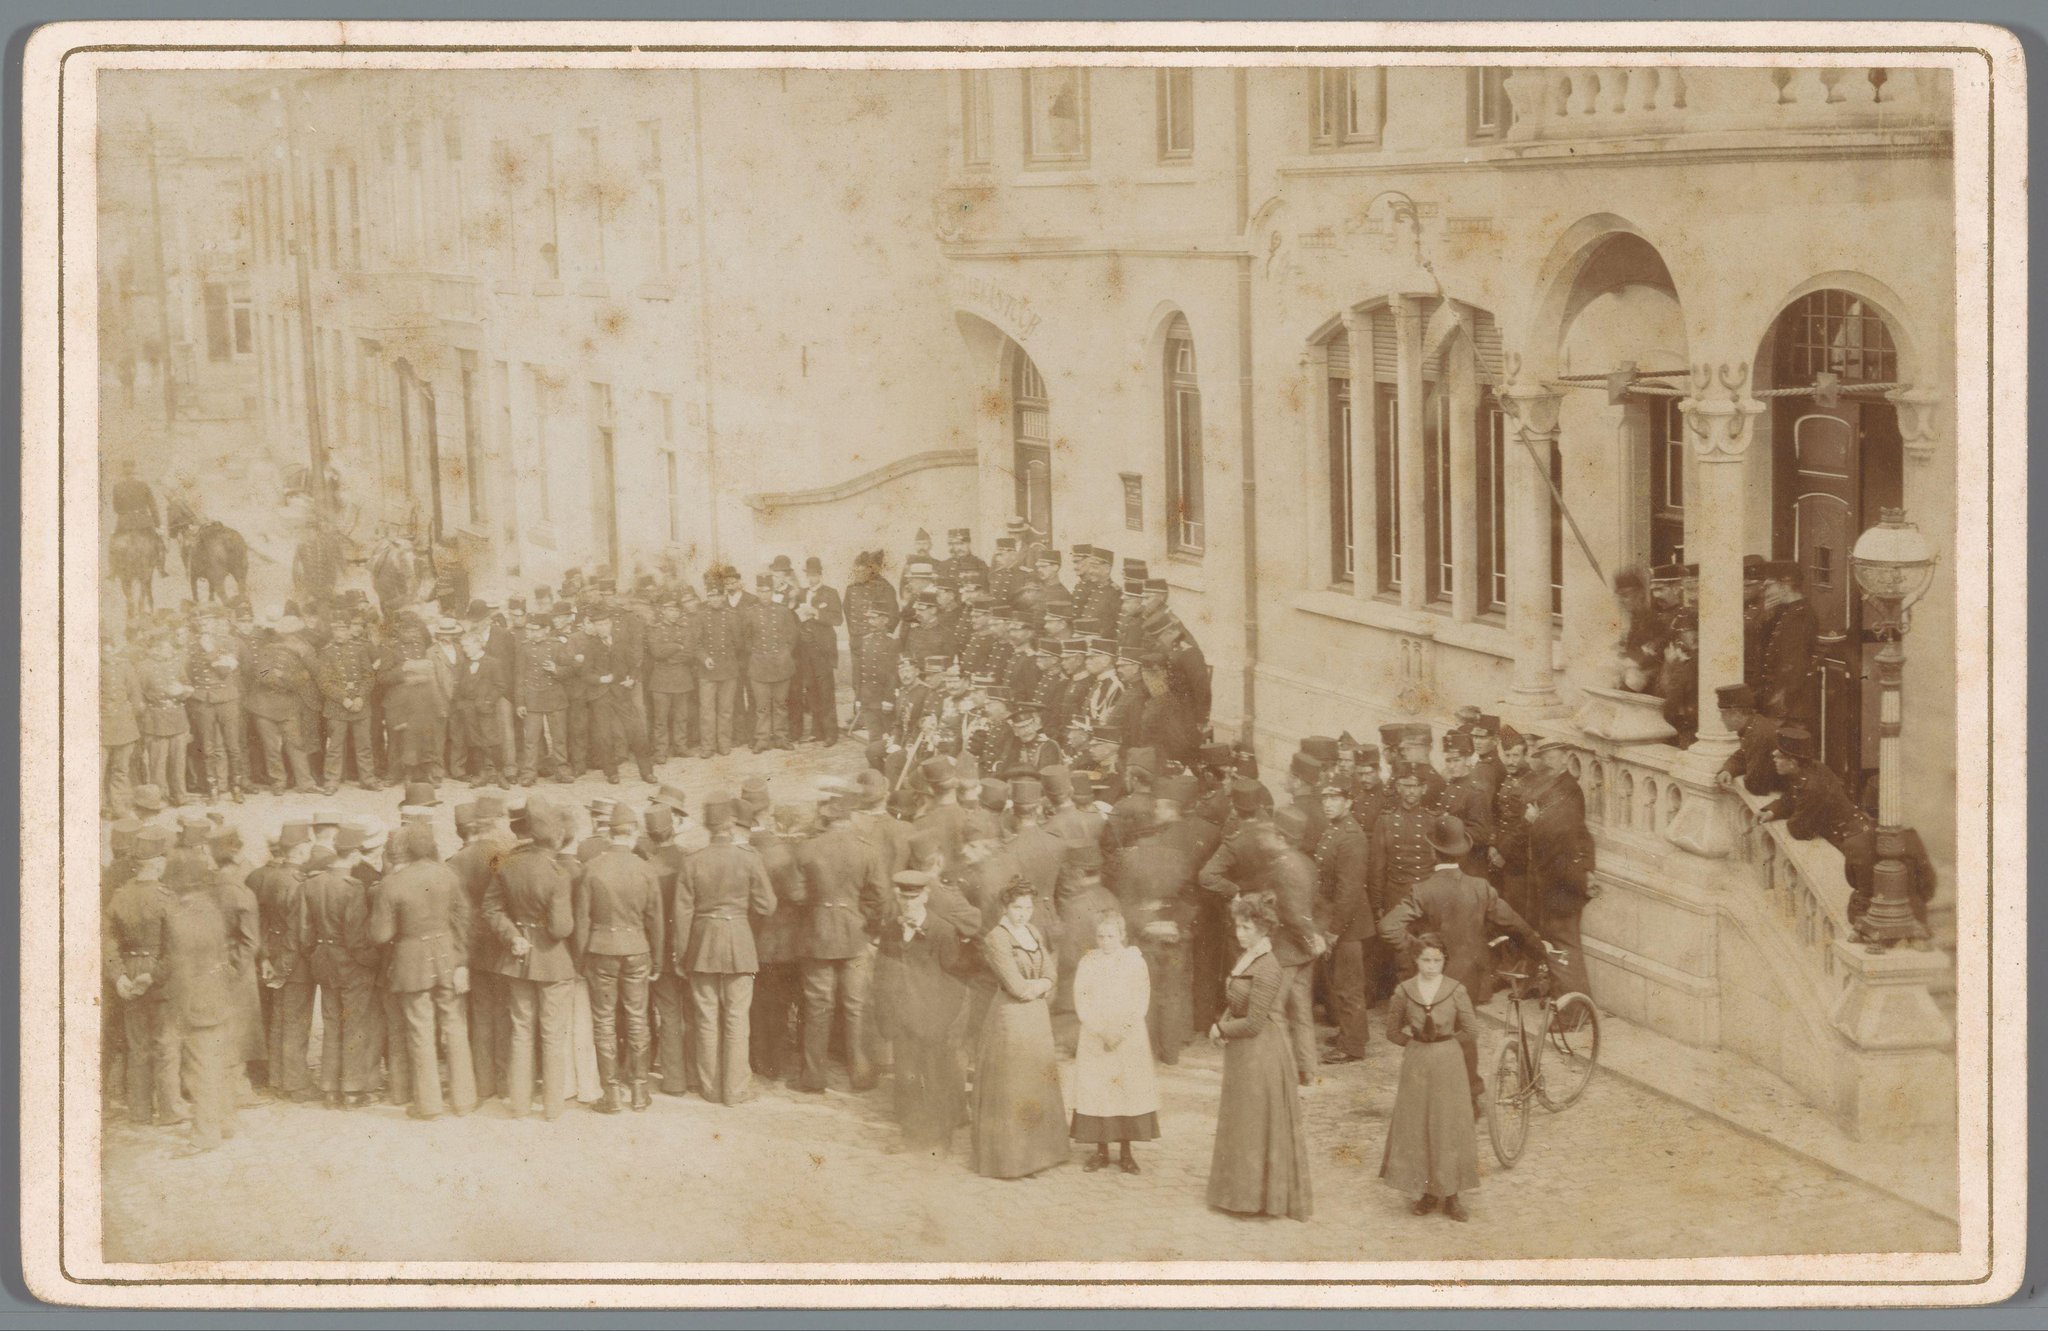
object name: cabinet photograph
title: Militairen voor het stadhuis van Valkenburg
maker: johan joachim cohnen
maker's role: publisher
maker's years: 1885-1947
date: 1901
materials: paper, cardboard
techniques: collodion silver print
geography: valkenburg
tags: manoeuvre ~ military training, military parade, pageant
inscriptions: stamp: ‘Photographische Atelier/ von/ Joh. Cohnen/ Valkenburg/ Groote Straat 130’, collector's mark: ‘Vosmaer’